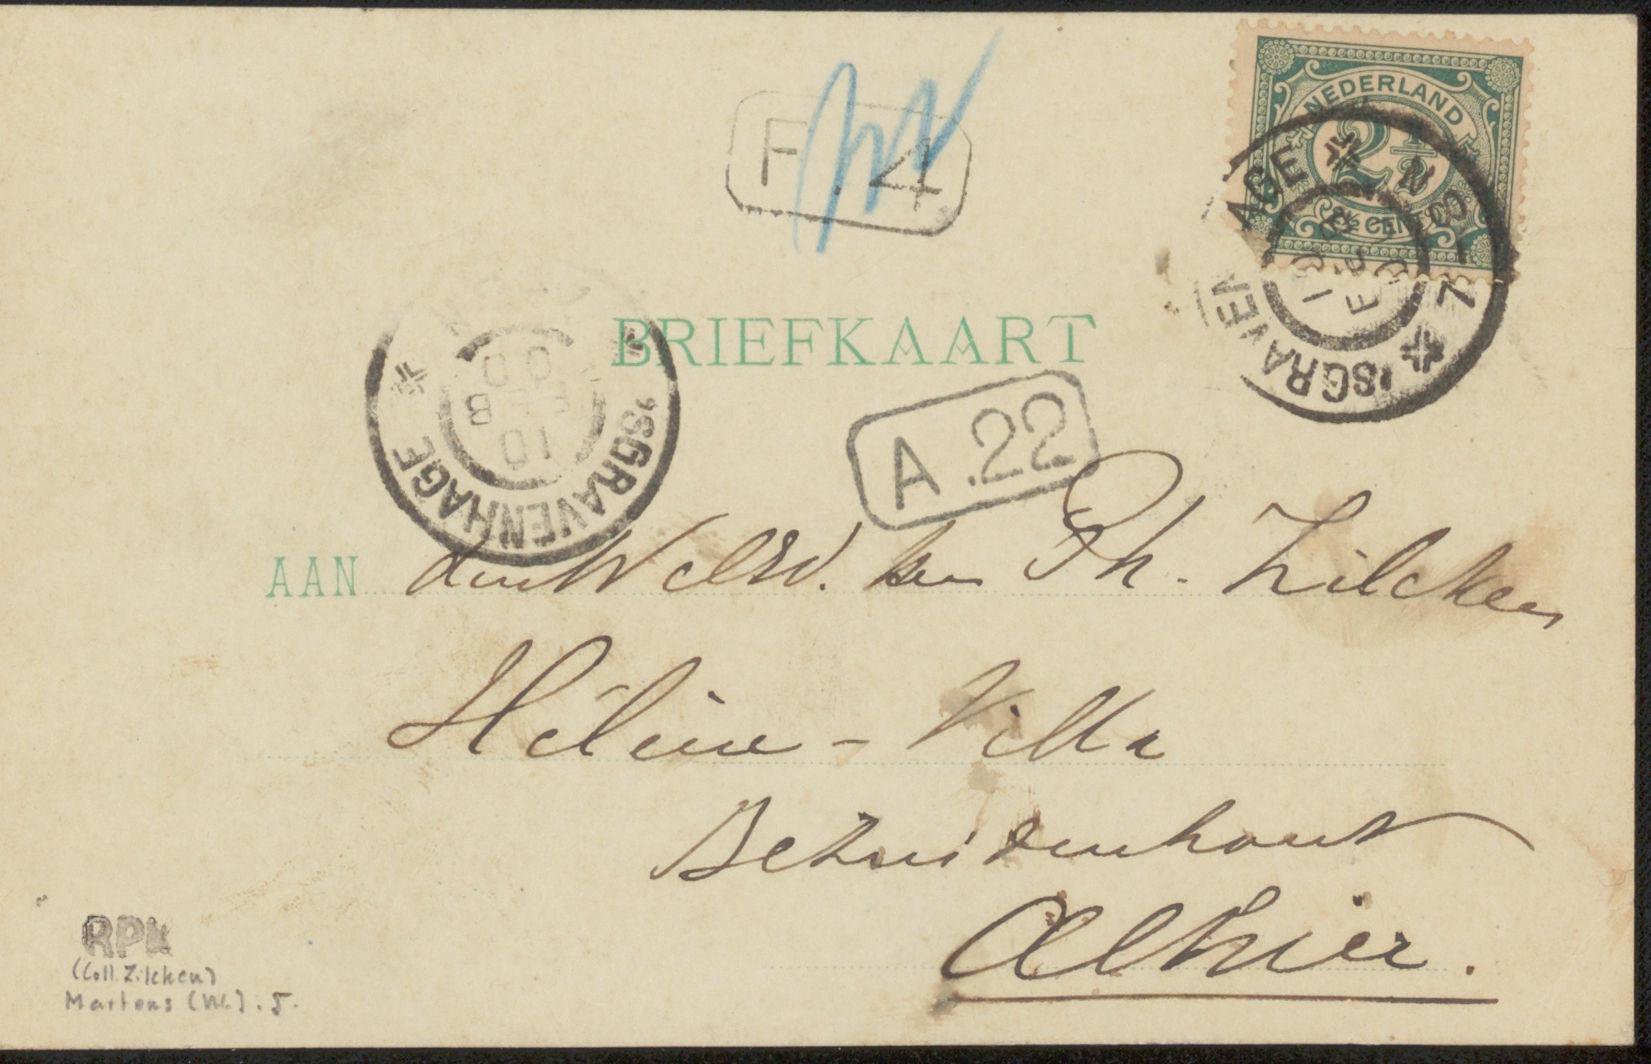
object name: postcard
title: Briefkaart aan Philip Zilcken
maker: willy martens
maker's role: painter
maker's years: 1856-1927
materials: cardboard, ink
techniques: pen, writing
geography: the hague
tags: philip zilcken, exhibition ~ art, paris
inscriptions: collector's mark: ‘RPK’